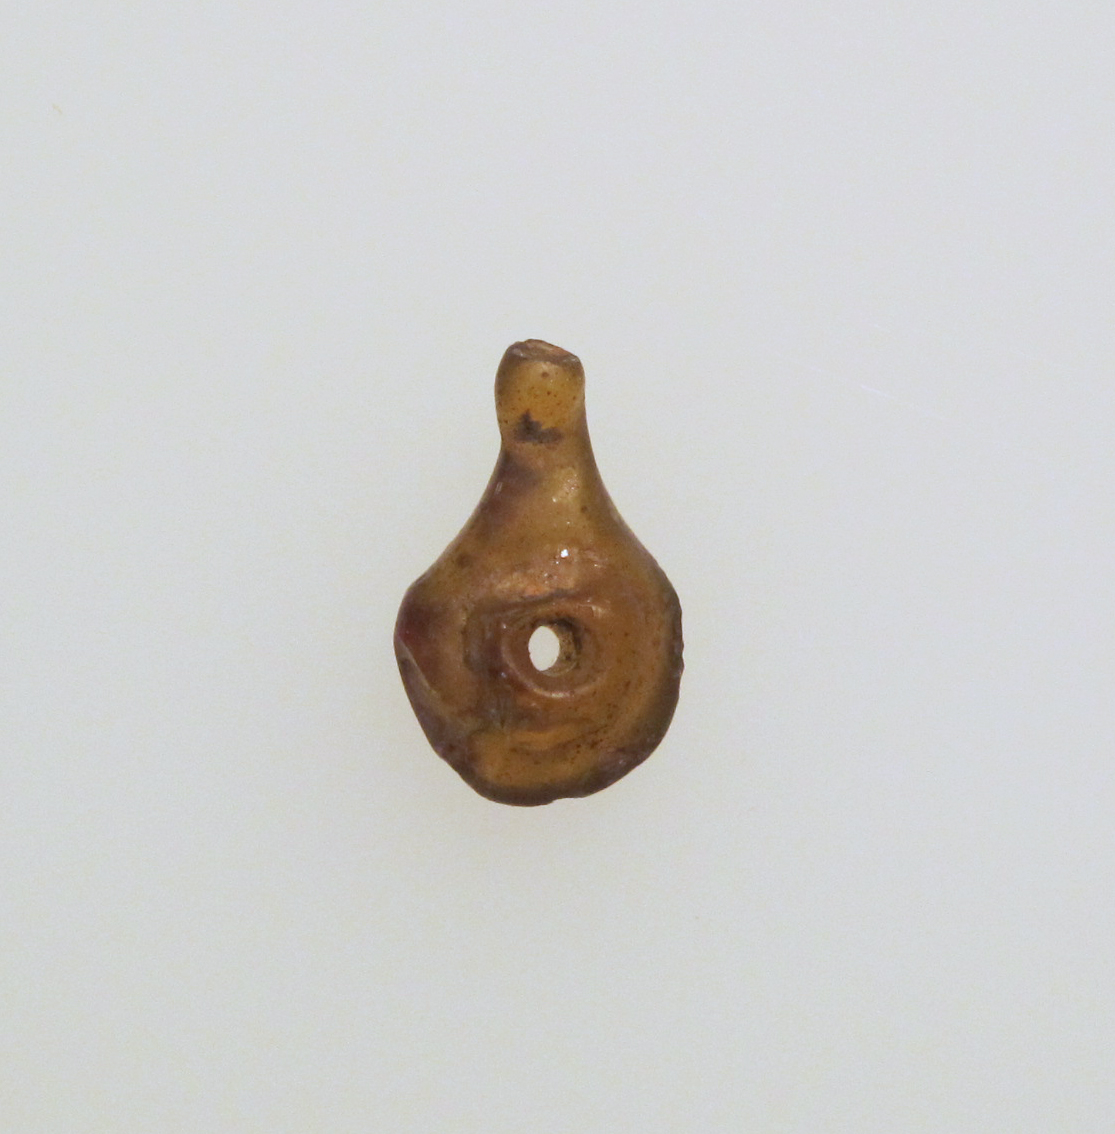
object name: lamp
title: Glass pendant in the form of a lamp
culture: hellenistic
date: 670 BCE-330 CE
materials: glass